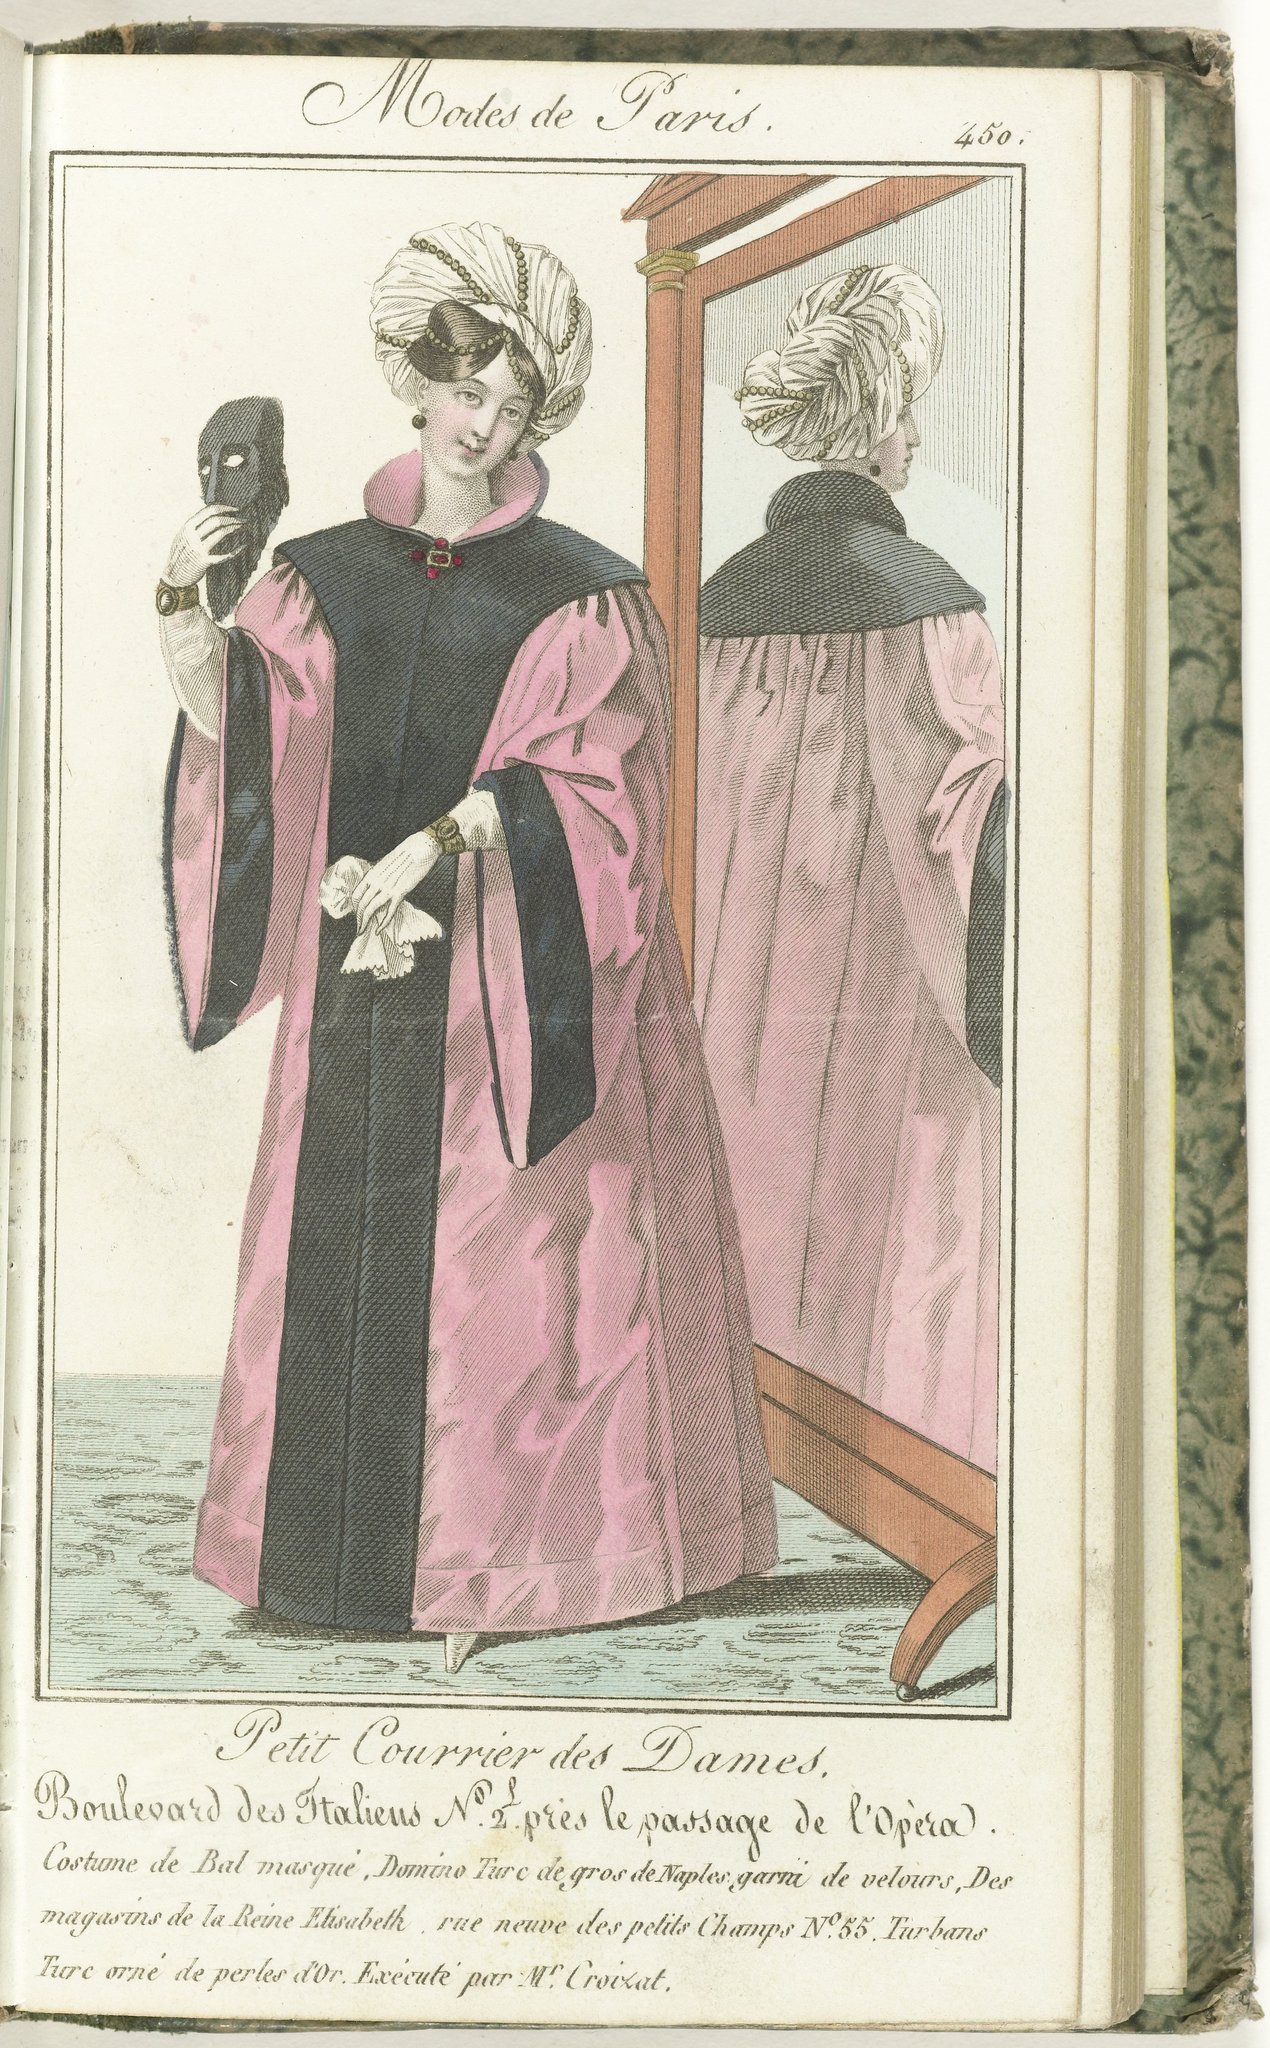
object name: fashion print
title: Petit Courrier des Dames, 20 février 1827, No. 450 : Costume de Bal masqué...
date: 1827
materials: paper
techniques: engraving, hand coloring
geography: paris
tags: handkerchief (+ women's clothes), brooch, agraffe, clasp (+ women's clothes), head-gear: turban (+ women's clothes), mask (+ women's clothes), party clothes, festive attire (+ women's clothes), coat (domino) (+ women's clothes), fashion plates, gloves, mittens, etc. (+ women's clothes), bracelet, wristlet (+ women's clothes)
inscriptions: title: ‘Modes de Paris.’, caption: ‘Costume de Bal masqué, Domino Turc de gros de Naples garni de velours, Des magasins de la Reine Elisabeth, rue neuve des petits Champs No. 55. Turbans Turc orné de perles d'Or. Exécuté par M.r Croizat.’, address: ‘Boulevard des Italiens No.2 près le passage de l'Opèra.’, title: ‘Petit Courrier des Dames.’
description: Staande vrouw, met de rug naar een passpiegel, gekleed in kostuum voor een gemaskerd bal. 'Domino Turc' van 'gros de Naples' versierd met fluweel. Op het hoofd een turkse tulband versierd met goudkleurige kralen, uitgevoerd door Croizat. In de hand een half masker met aan de onderkant een stukje stof. Prent uit het modetijdschrift Petit Courrier des Dames (1821-1868). Ingebonden (met enkele pp. Le Journal des Dames et des Modes). 15 Januari 1827 t/m 20 maart 1830. Incompleet.